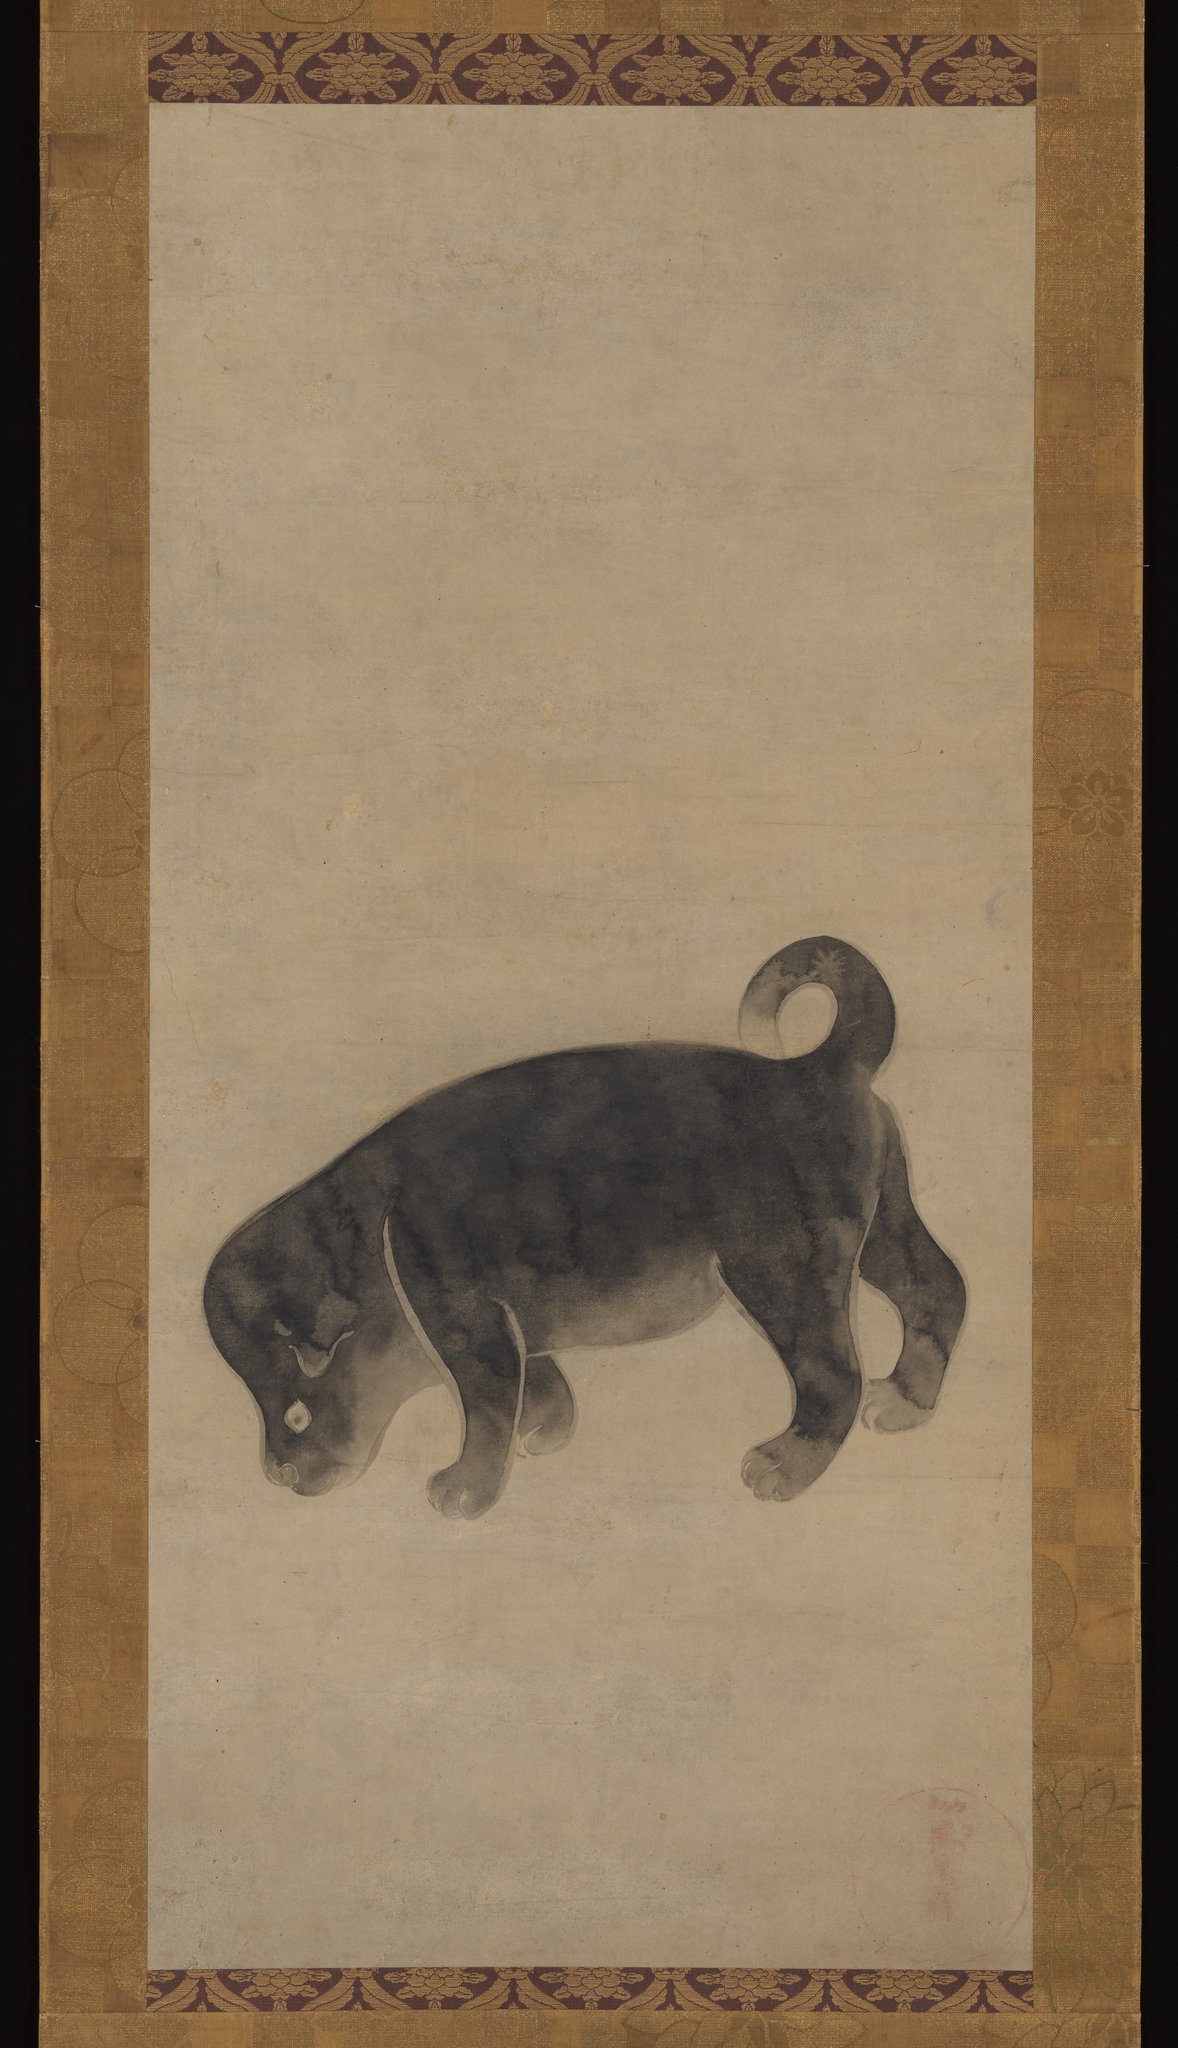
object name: hanging scroll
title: Puppy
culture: japanese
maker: studio of tawaraya sōtatsu 俵屋宗達工房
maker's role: artist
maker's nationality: japanese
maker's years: 1570-1640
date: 1601-1633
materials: ink, paper